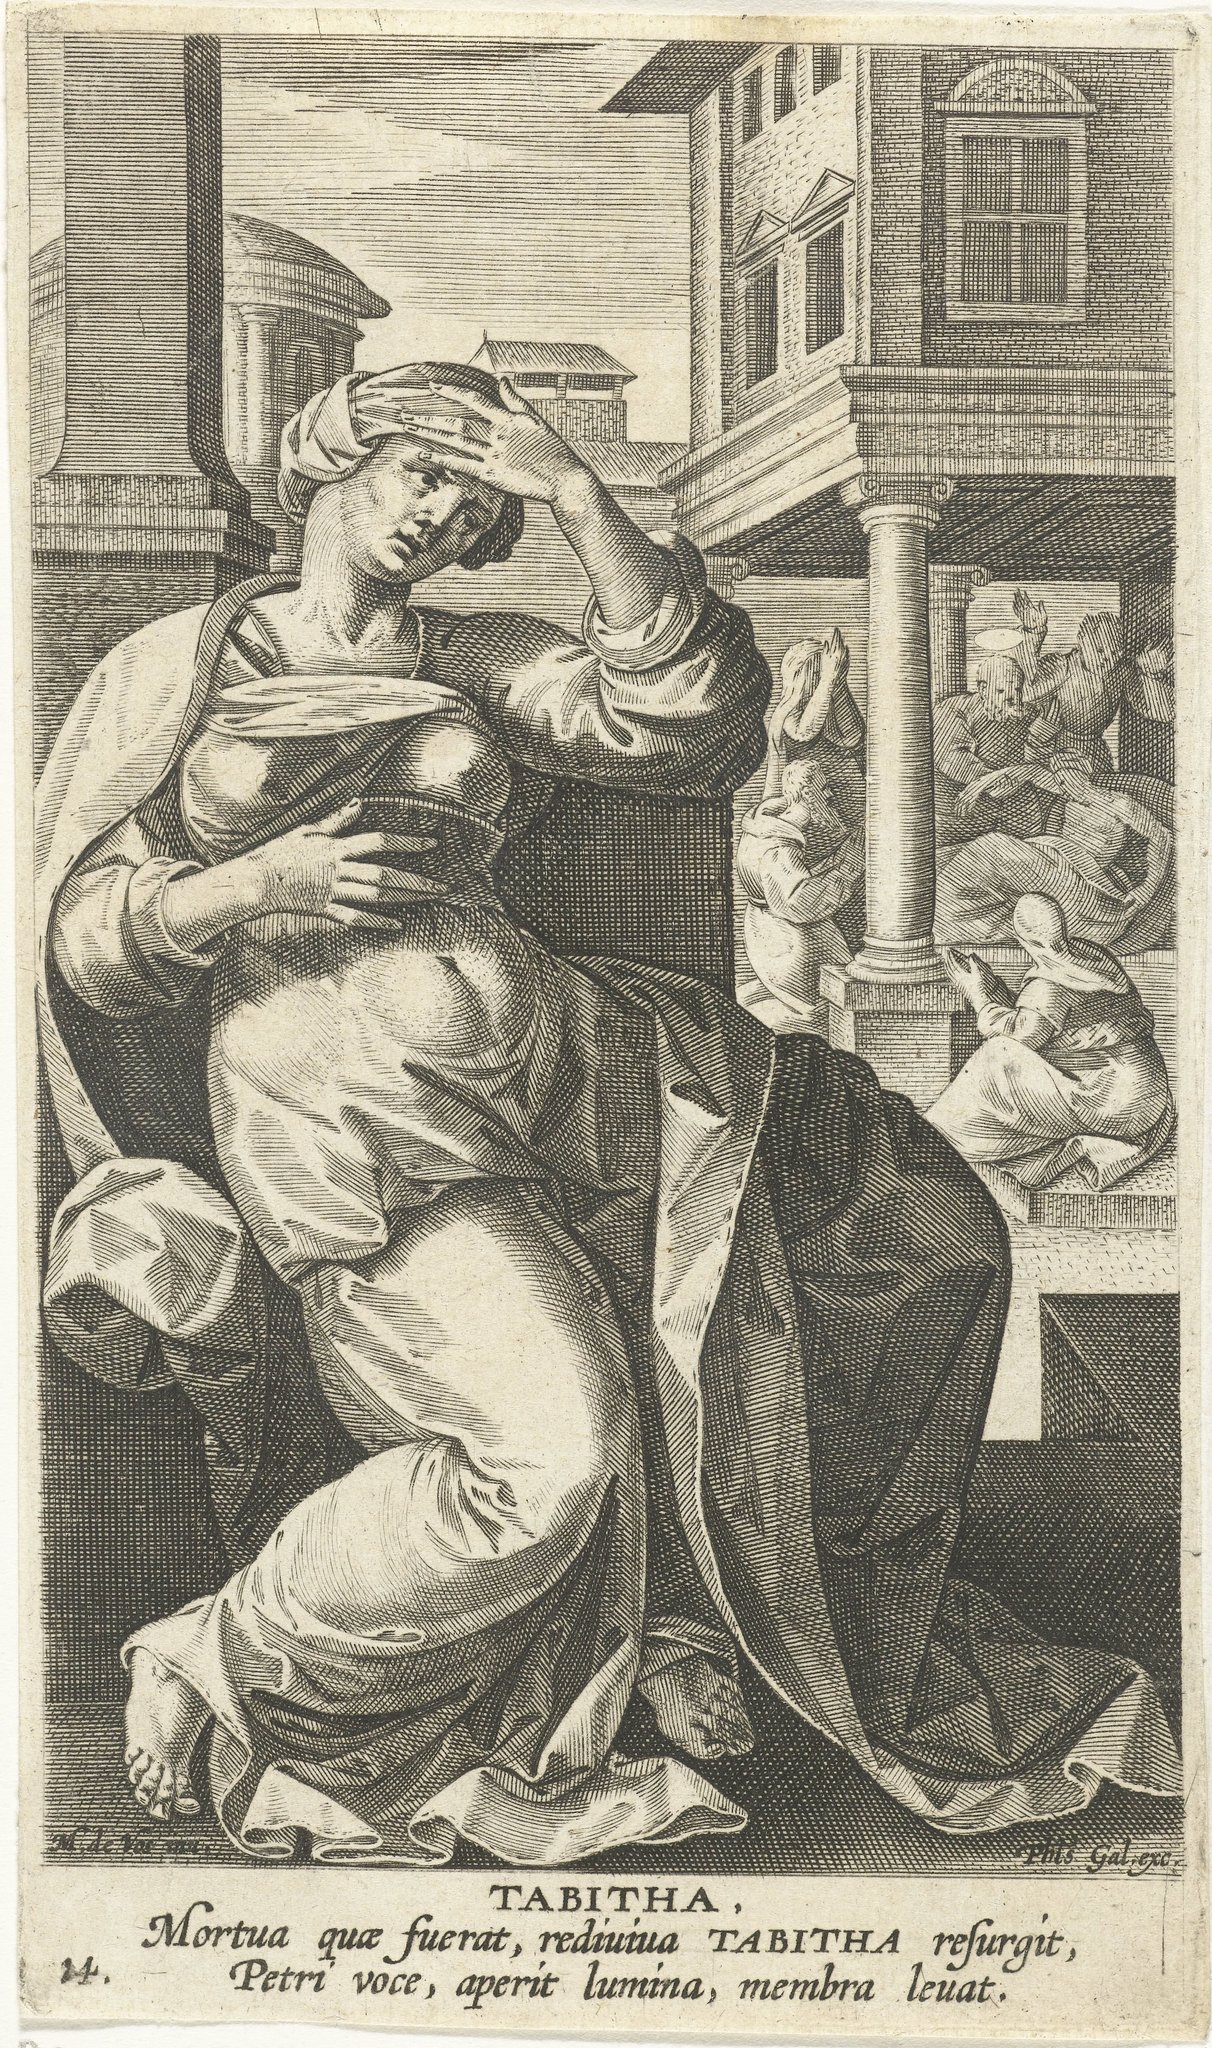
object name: print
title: Tabitha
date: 1595-1599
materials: paper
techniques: engraving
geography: antwerp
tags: tabitha is raised from the dead by peter's prayer, female persons from the new testament (with name) (not in biblical context)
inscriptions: collector's mark: Lugt 2228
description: Op de voorgrond zit de zieke Tabita (Dorkas). Op de achtergrond wekt Petrus Tabita na haar dood tot leven. De prent heeft een Latijns onderschrift en maakt deel uit van een prentserie met beroemde vrouwen uit het Nieuwe Testament